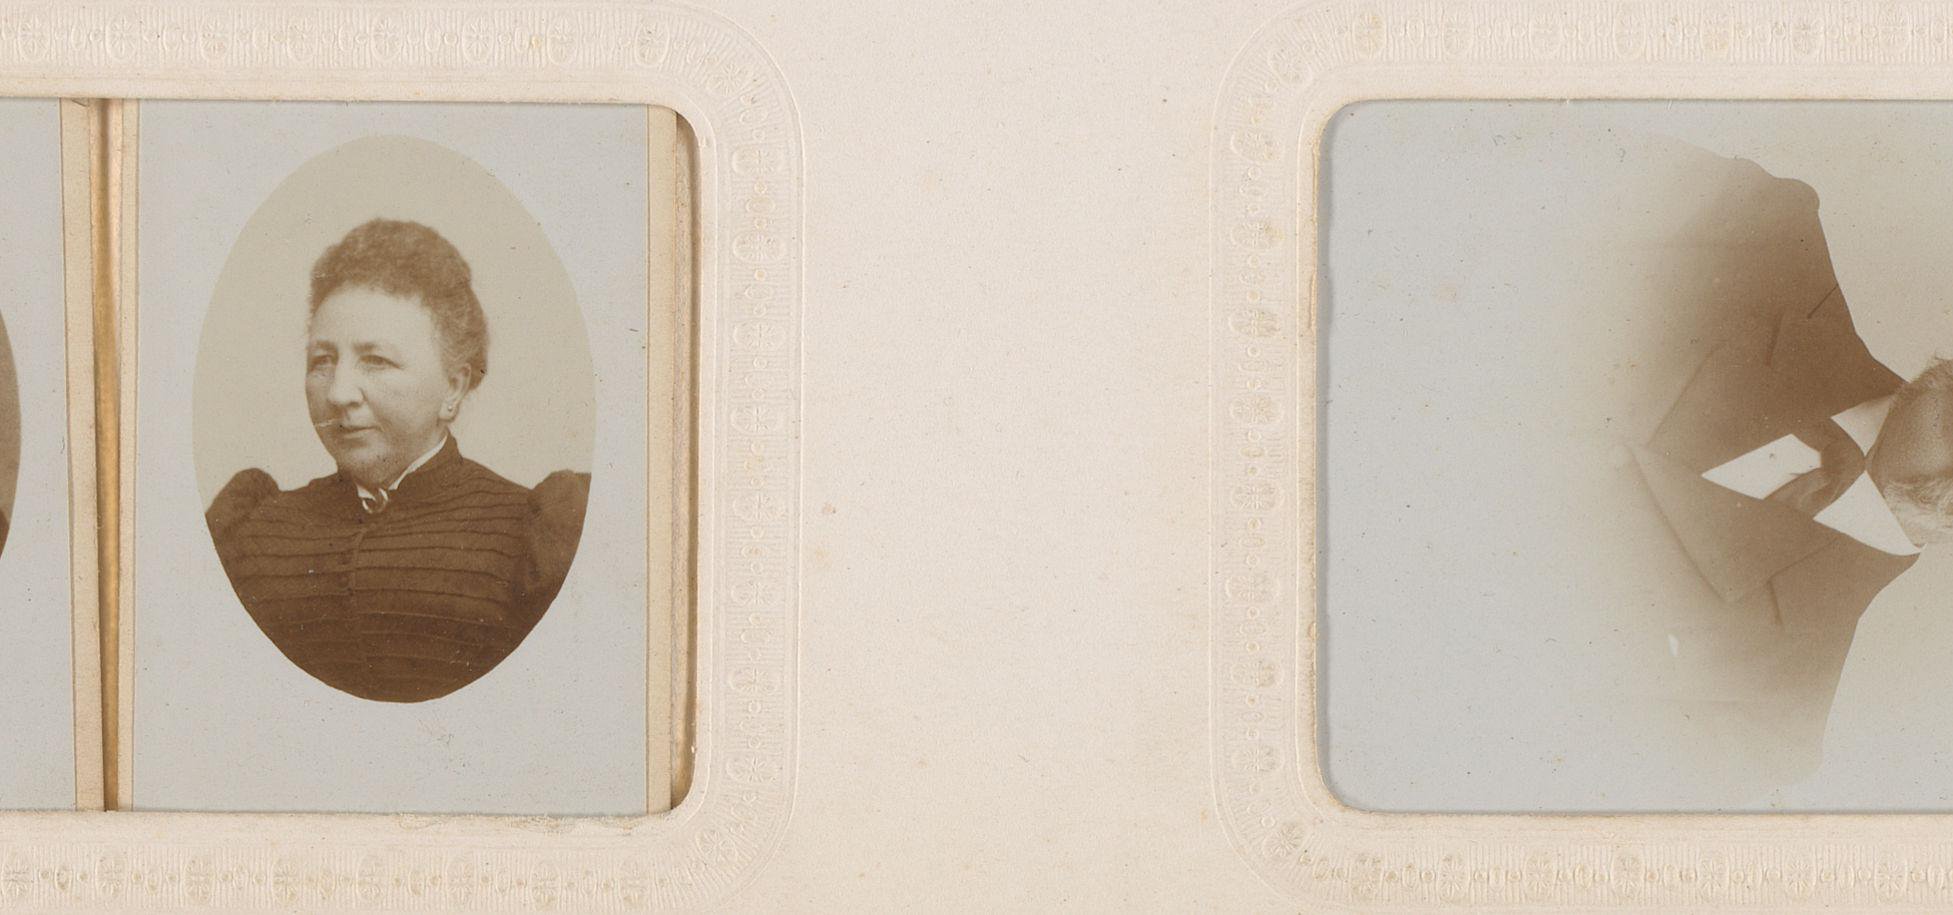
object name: photograph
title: Portret van een man met snor en baard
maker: Anonymous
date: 1880-1920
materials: cardboard, photographic support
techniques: collodion silver print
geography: netherlands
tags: moustache, historical persons, beard